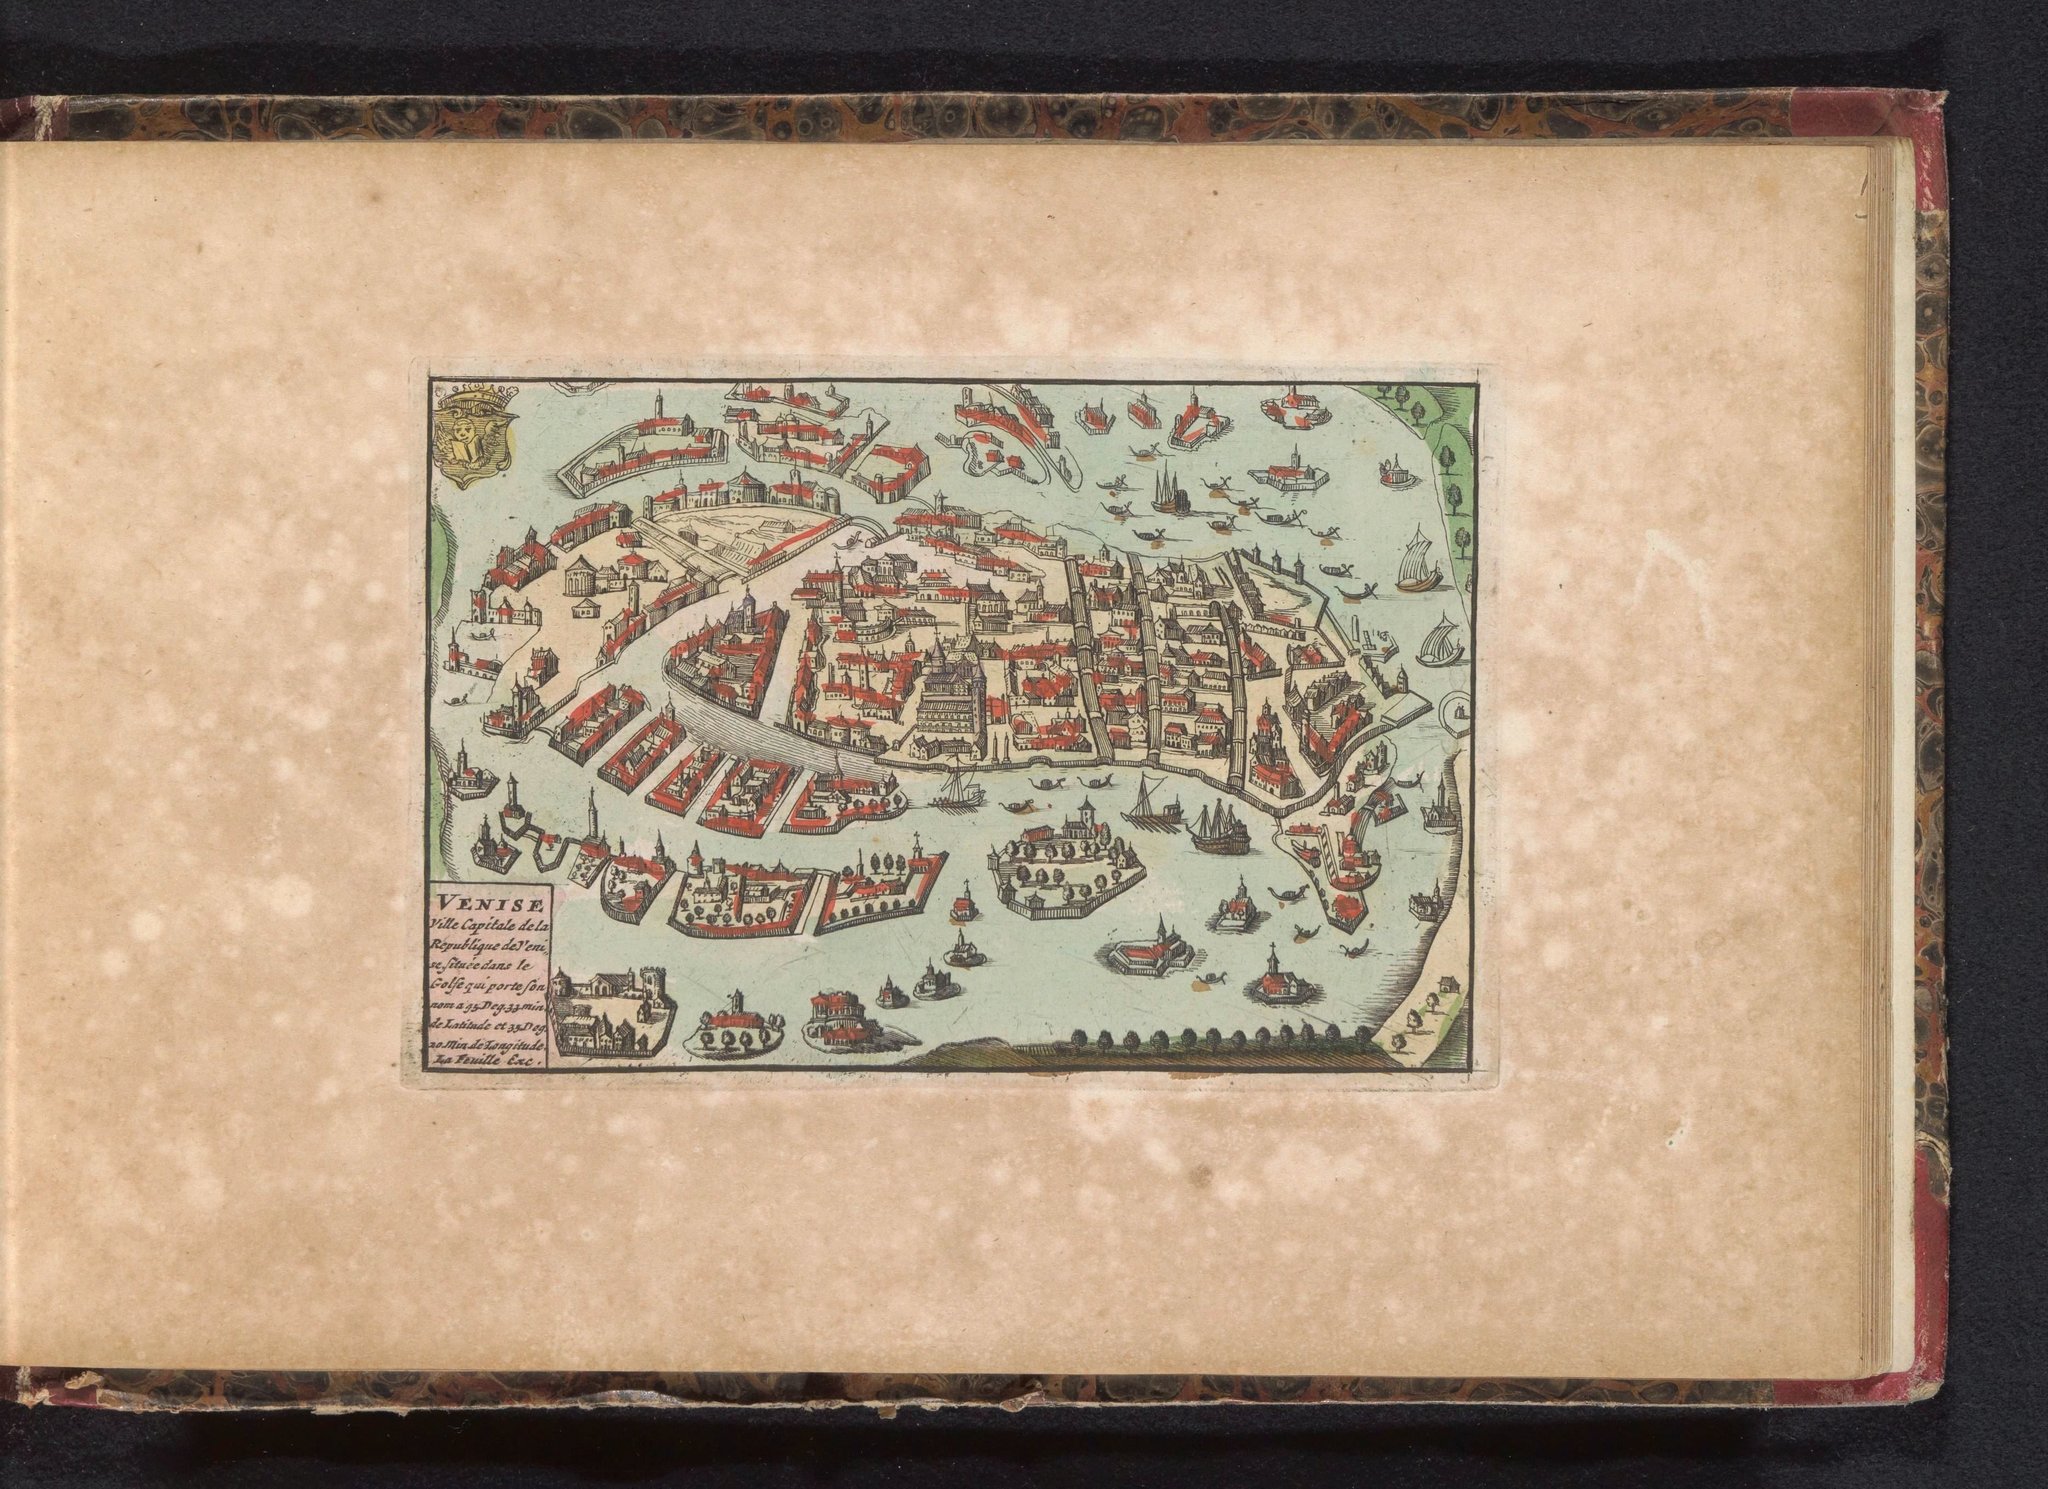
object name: map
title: Plattegrond van Venetië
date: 1700-1702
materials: paper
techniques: engraving, etching, hand coloring, lacquer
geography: amsterdam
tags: maps of cities, venice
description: Plattegrond van de stad Venetië, in vogelvlucht. Onderdeel van een atlas met 223 kaarten van landen en steden en oorlogstaferelen in Europa in de periode ca. 1690-1735.